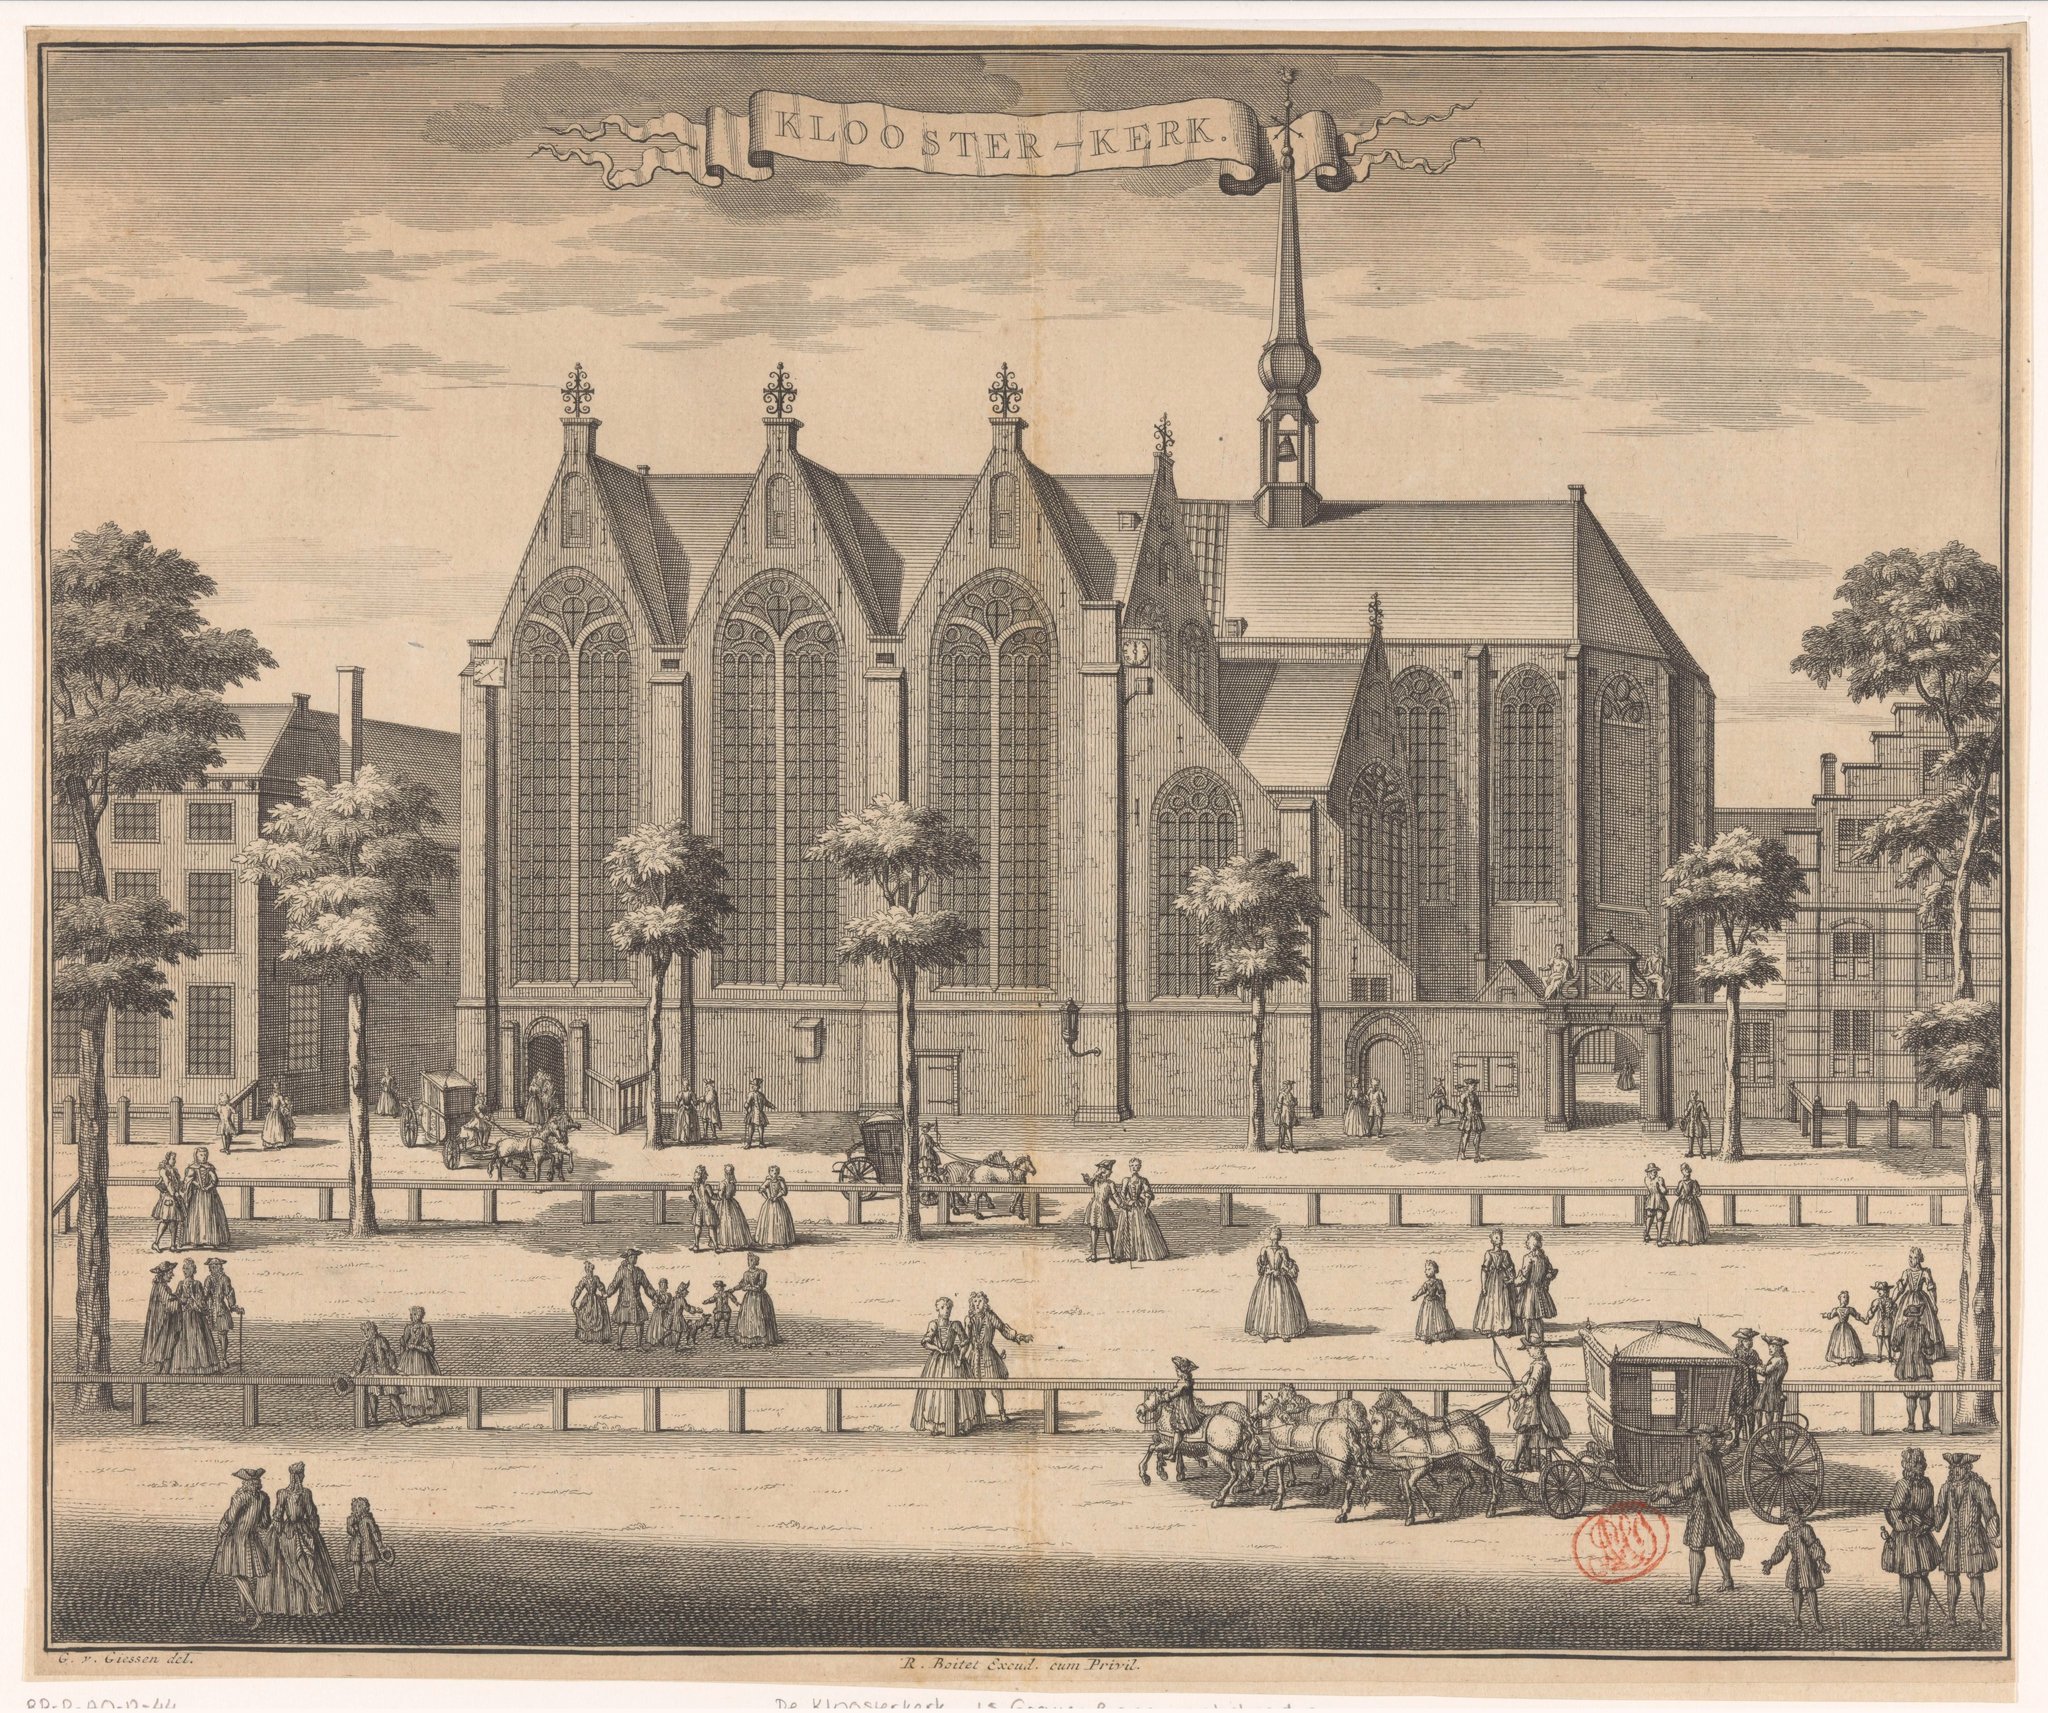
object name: print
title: Klooster-kerk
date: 1730-1736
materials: paper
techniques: engraving, etching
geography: the hague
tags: church (exterior), street (+ city(-scape) with figures, staffage)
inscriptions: collector's mark: Lugt 2228, collector's mark: Lugt 195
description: Gezicht op de Kloosterkerk aan het Lange Voorhout te Den Haag. Voor de kerk verschillende figuren en koetsen.